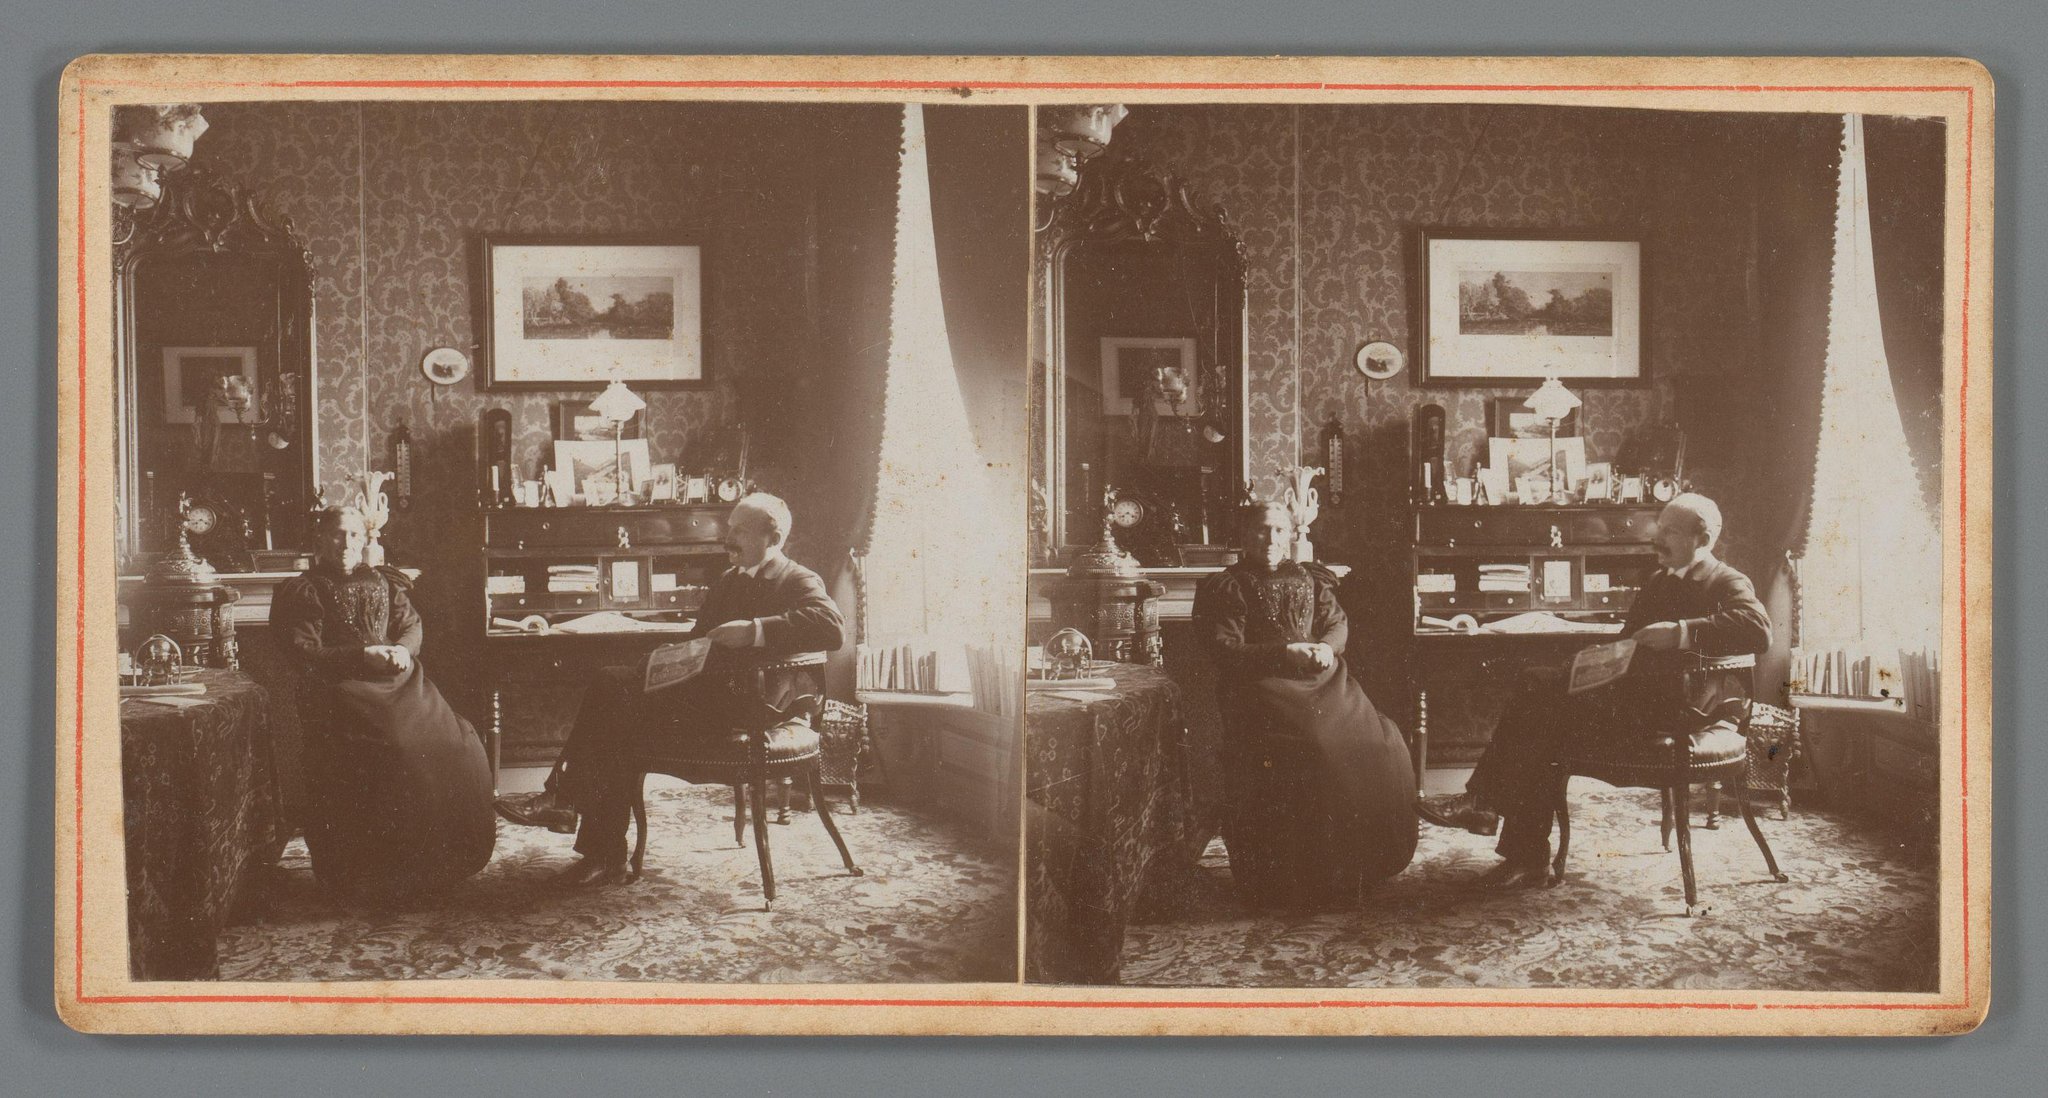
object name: stereograph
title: Johanna de Jong-Voet met zoon Piet de Jong in zijn huis in Arnhem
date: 1900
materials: paper, cardboard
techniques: collodion silver print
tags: johanna petronella de jong-voet, haarlem, piet de jong (fotograaf), historical persons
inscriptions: inscription: ‘Dr. P. de Jong/ mevrouw J. de Jong-Voet/ (moeder)’, inscription: ‘(huis/ Piet/ de Jong)’, address: ‘Velperplein 14, Arnhem’, date: ‘ca. 1900’